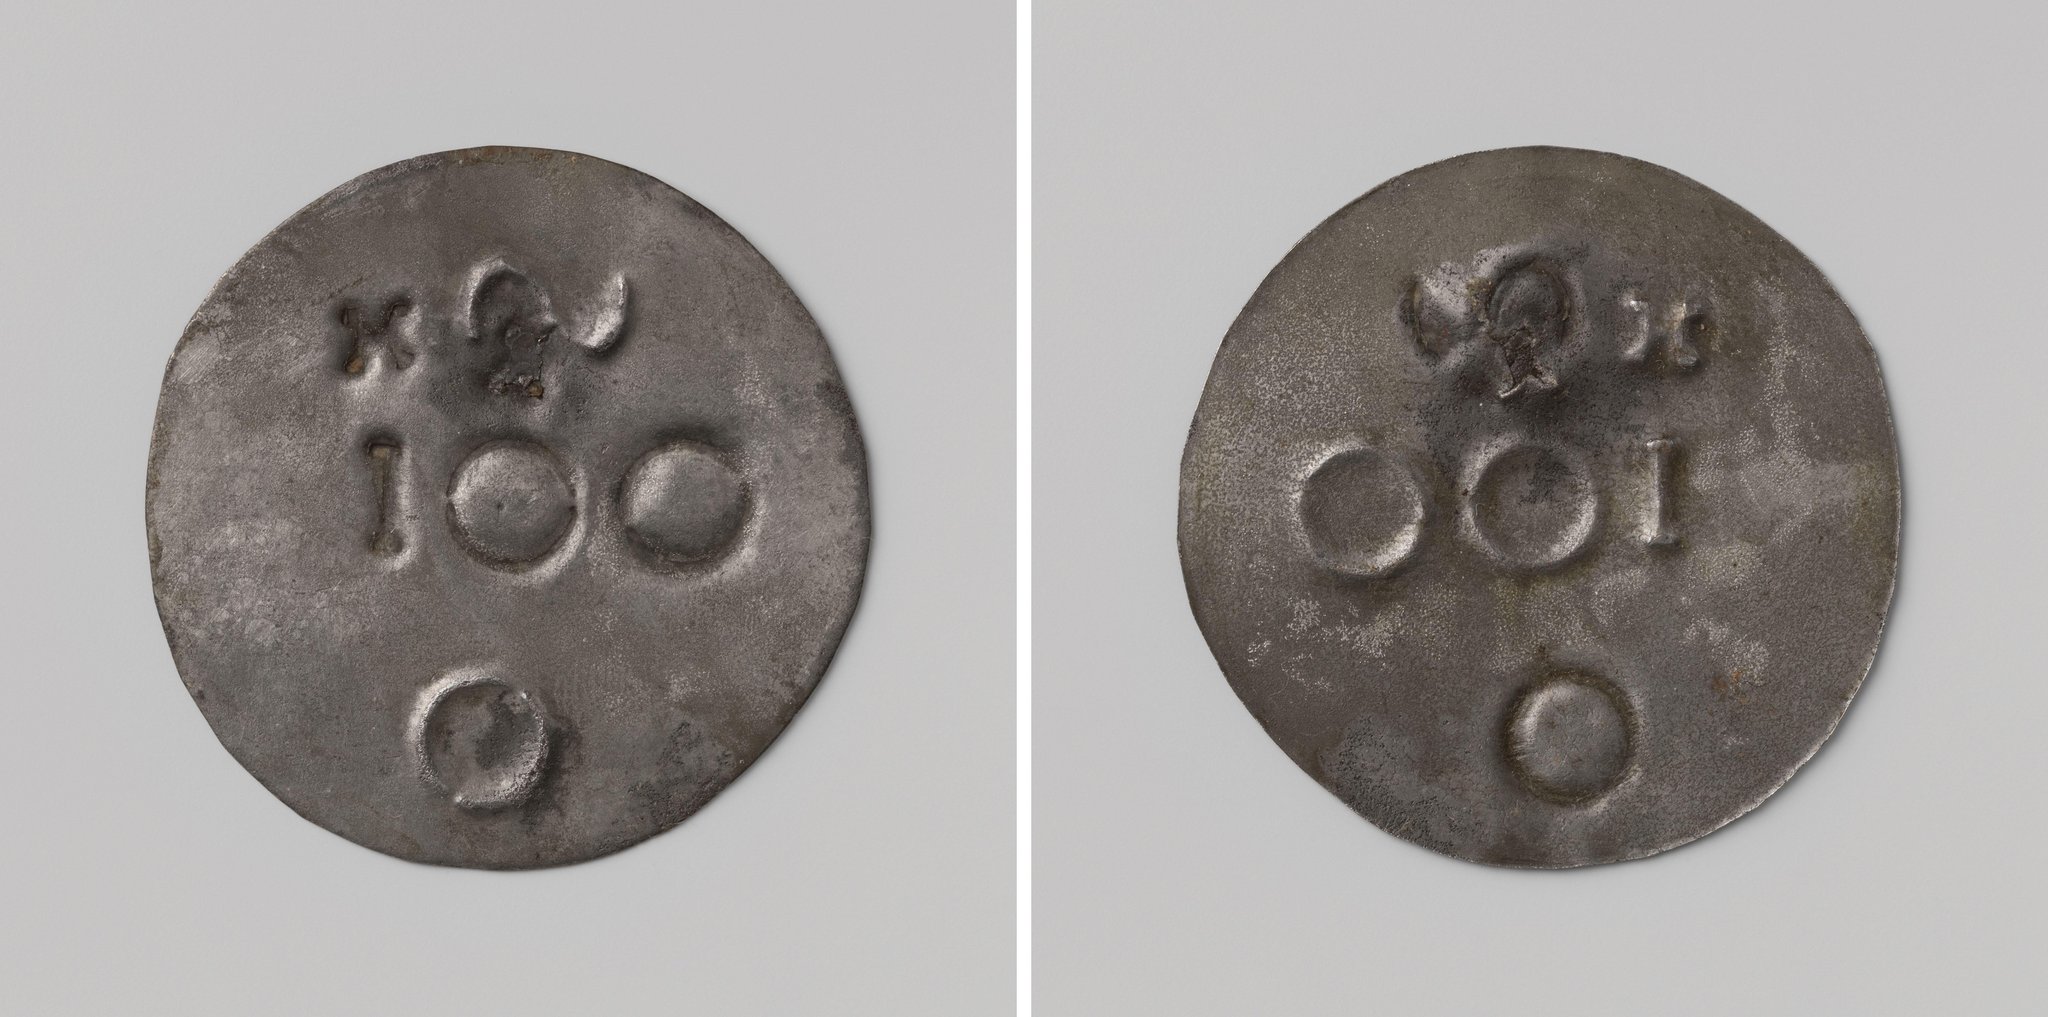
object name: monetary token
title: Huismunt ter waarde van honderd cent, van de Strafgevangenis Ommerschans of van het Correctiehuis Sint Bernard?, geslagen op last van de Maatschappij van Weldadigheid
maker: Anonymous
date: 1822-1830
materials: metal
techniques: striking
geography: ommerschans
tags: maatschappij van weldadigheid, ommerschans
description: eenzijdige munt. Voorzijde: waardeaanduiding onder merk en tussen de verticaal geplaatste letters O en S. Keerzijde: blanco